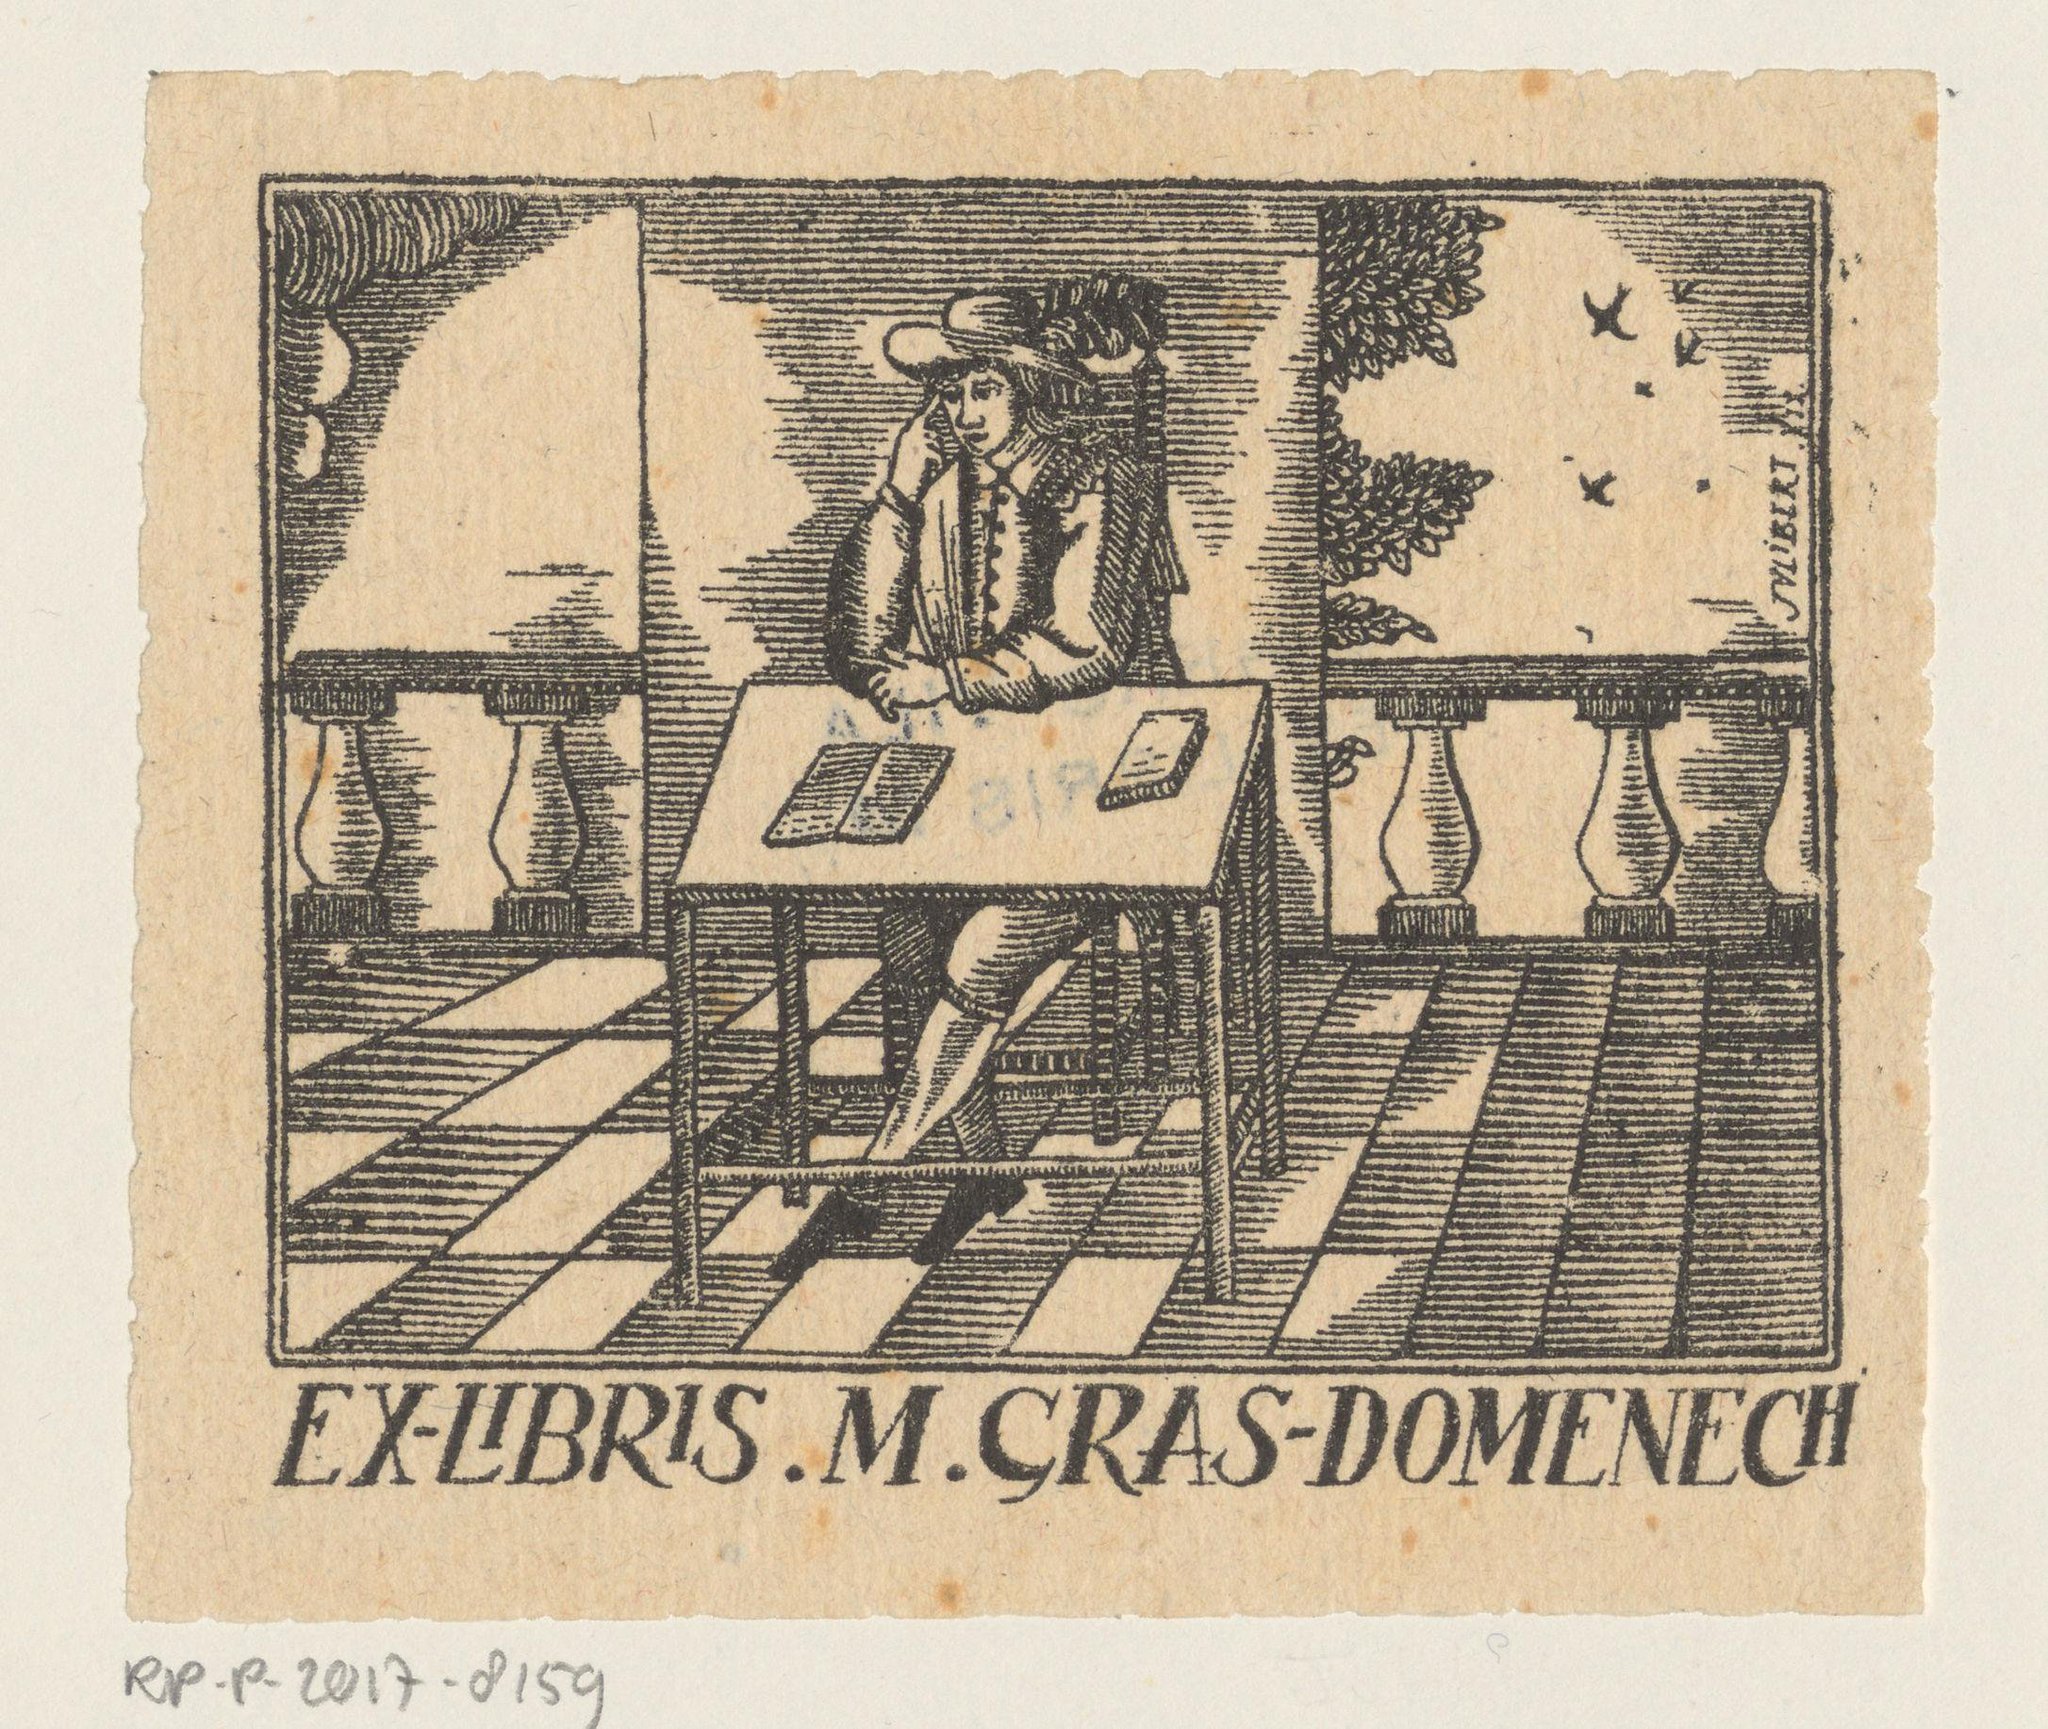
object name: bookplate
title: Ex libris van M. Gras-Domenech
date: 1900-1949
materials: paper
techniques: printing block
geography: spain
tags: sitting figure, birds, historical costume, book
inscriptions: stamp: ‘M. Gras Vila/ ex-libris no.4’